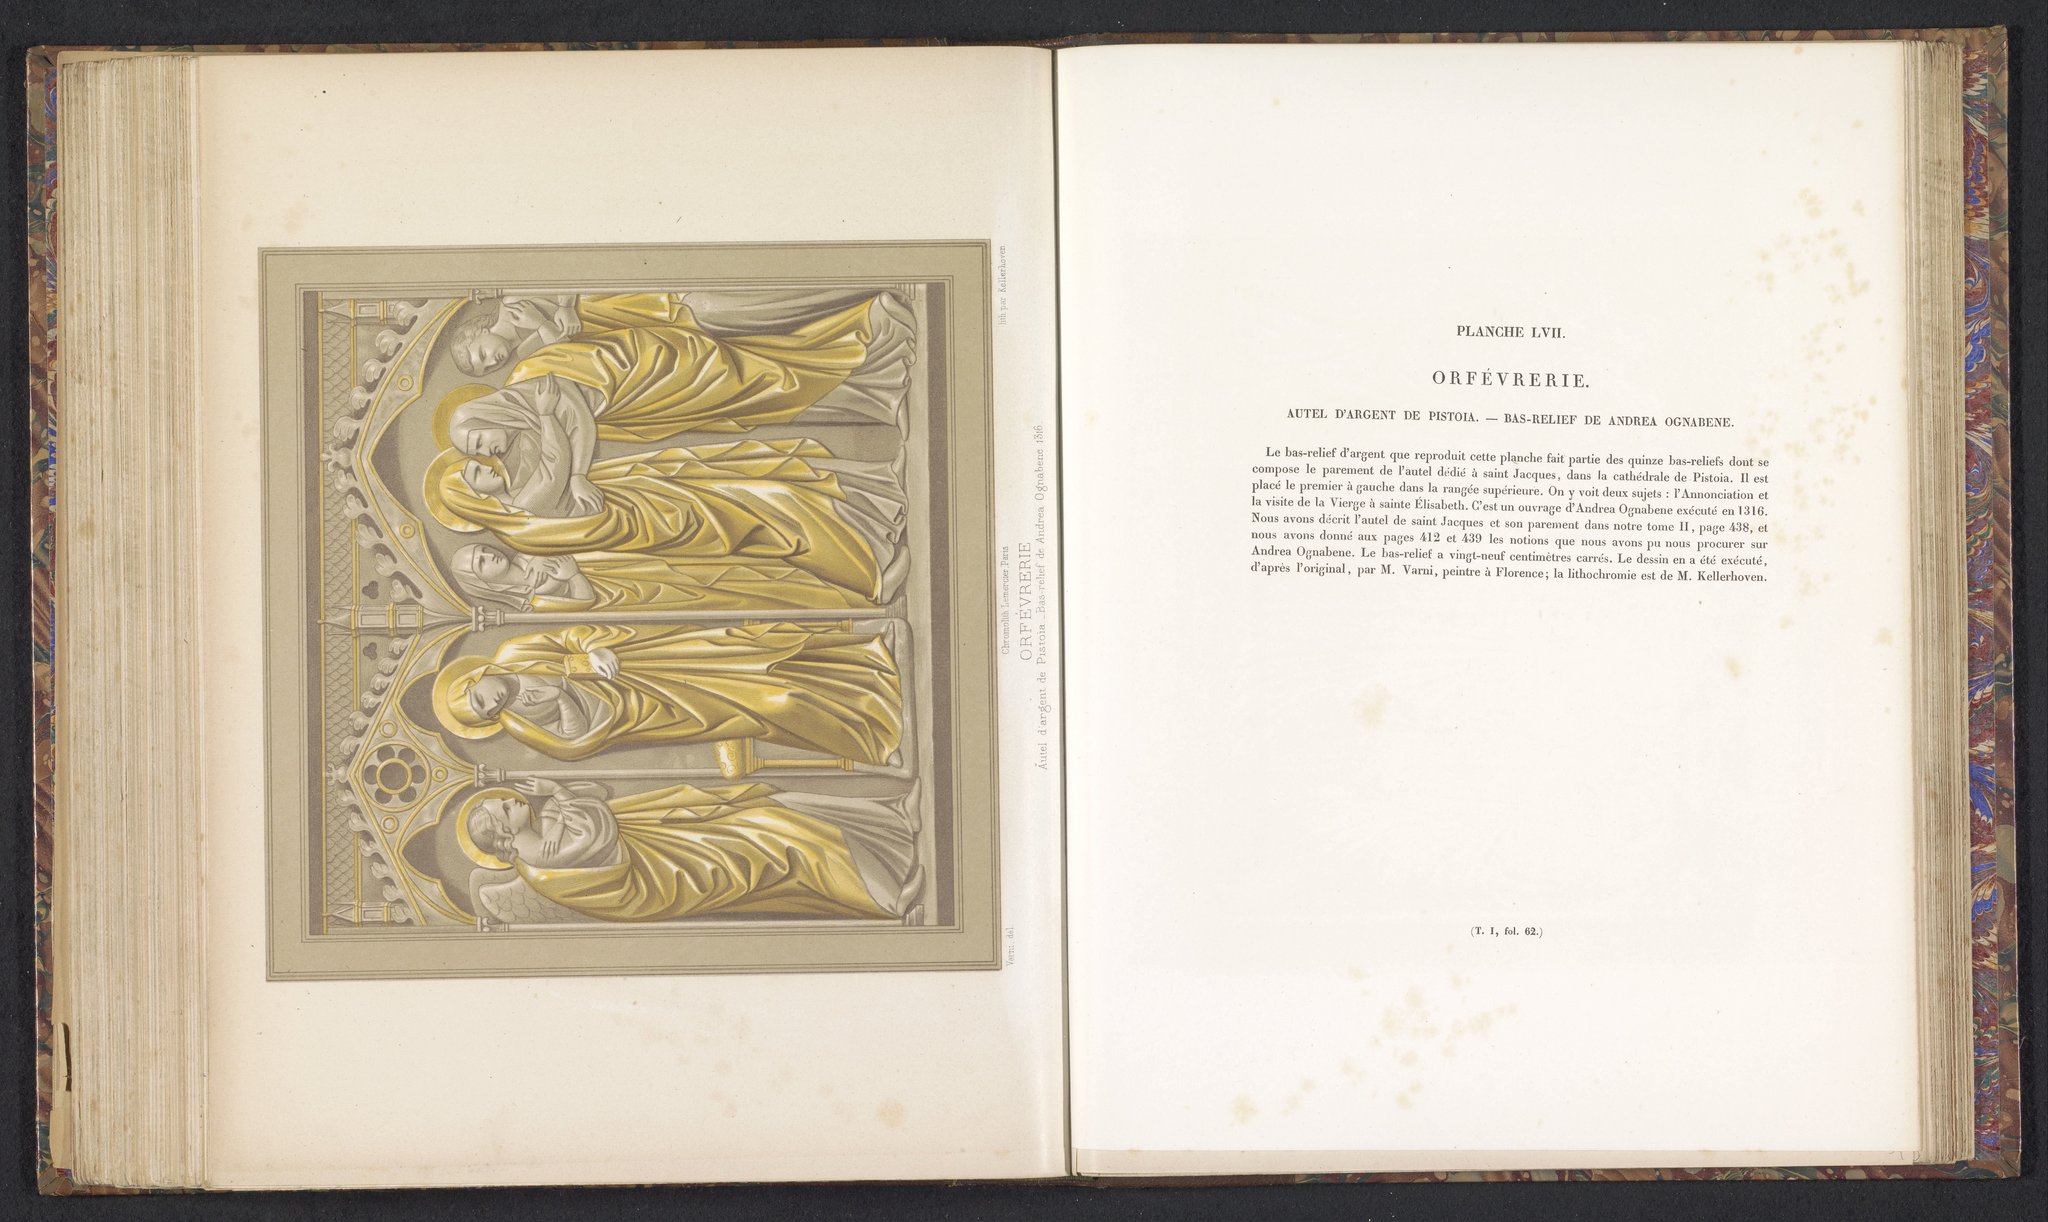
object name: print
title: Bas-reliëf op het altaar voor de heilige Jakobus de Meerdere in de Kathedraal van Pistoia, voorstellende de Annunciatie en de Visitatie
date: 1859-1864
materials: paper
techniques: chromolithography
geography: paris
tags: the annunciation: mary standing, mary and elisabeth, both pregnant, embracing, altar, sculpture (+ relief ~ sculpture)